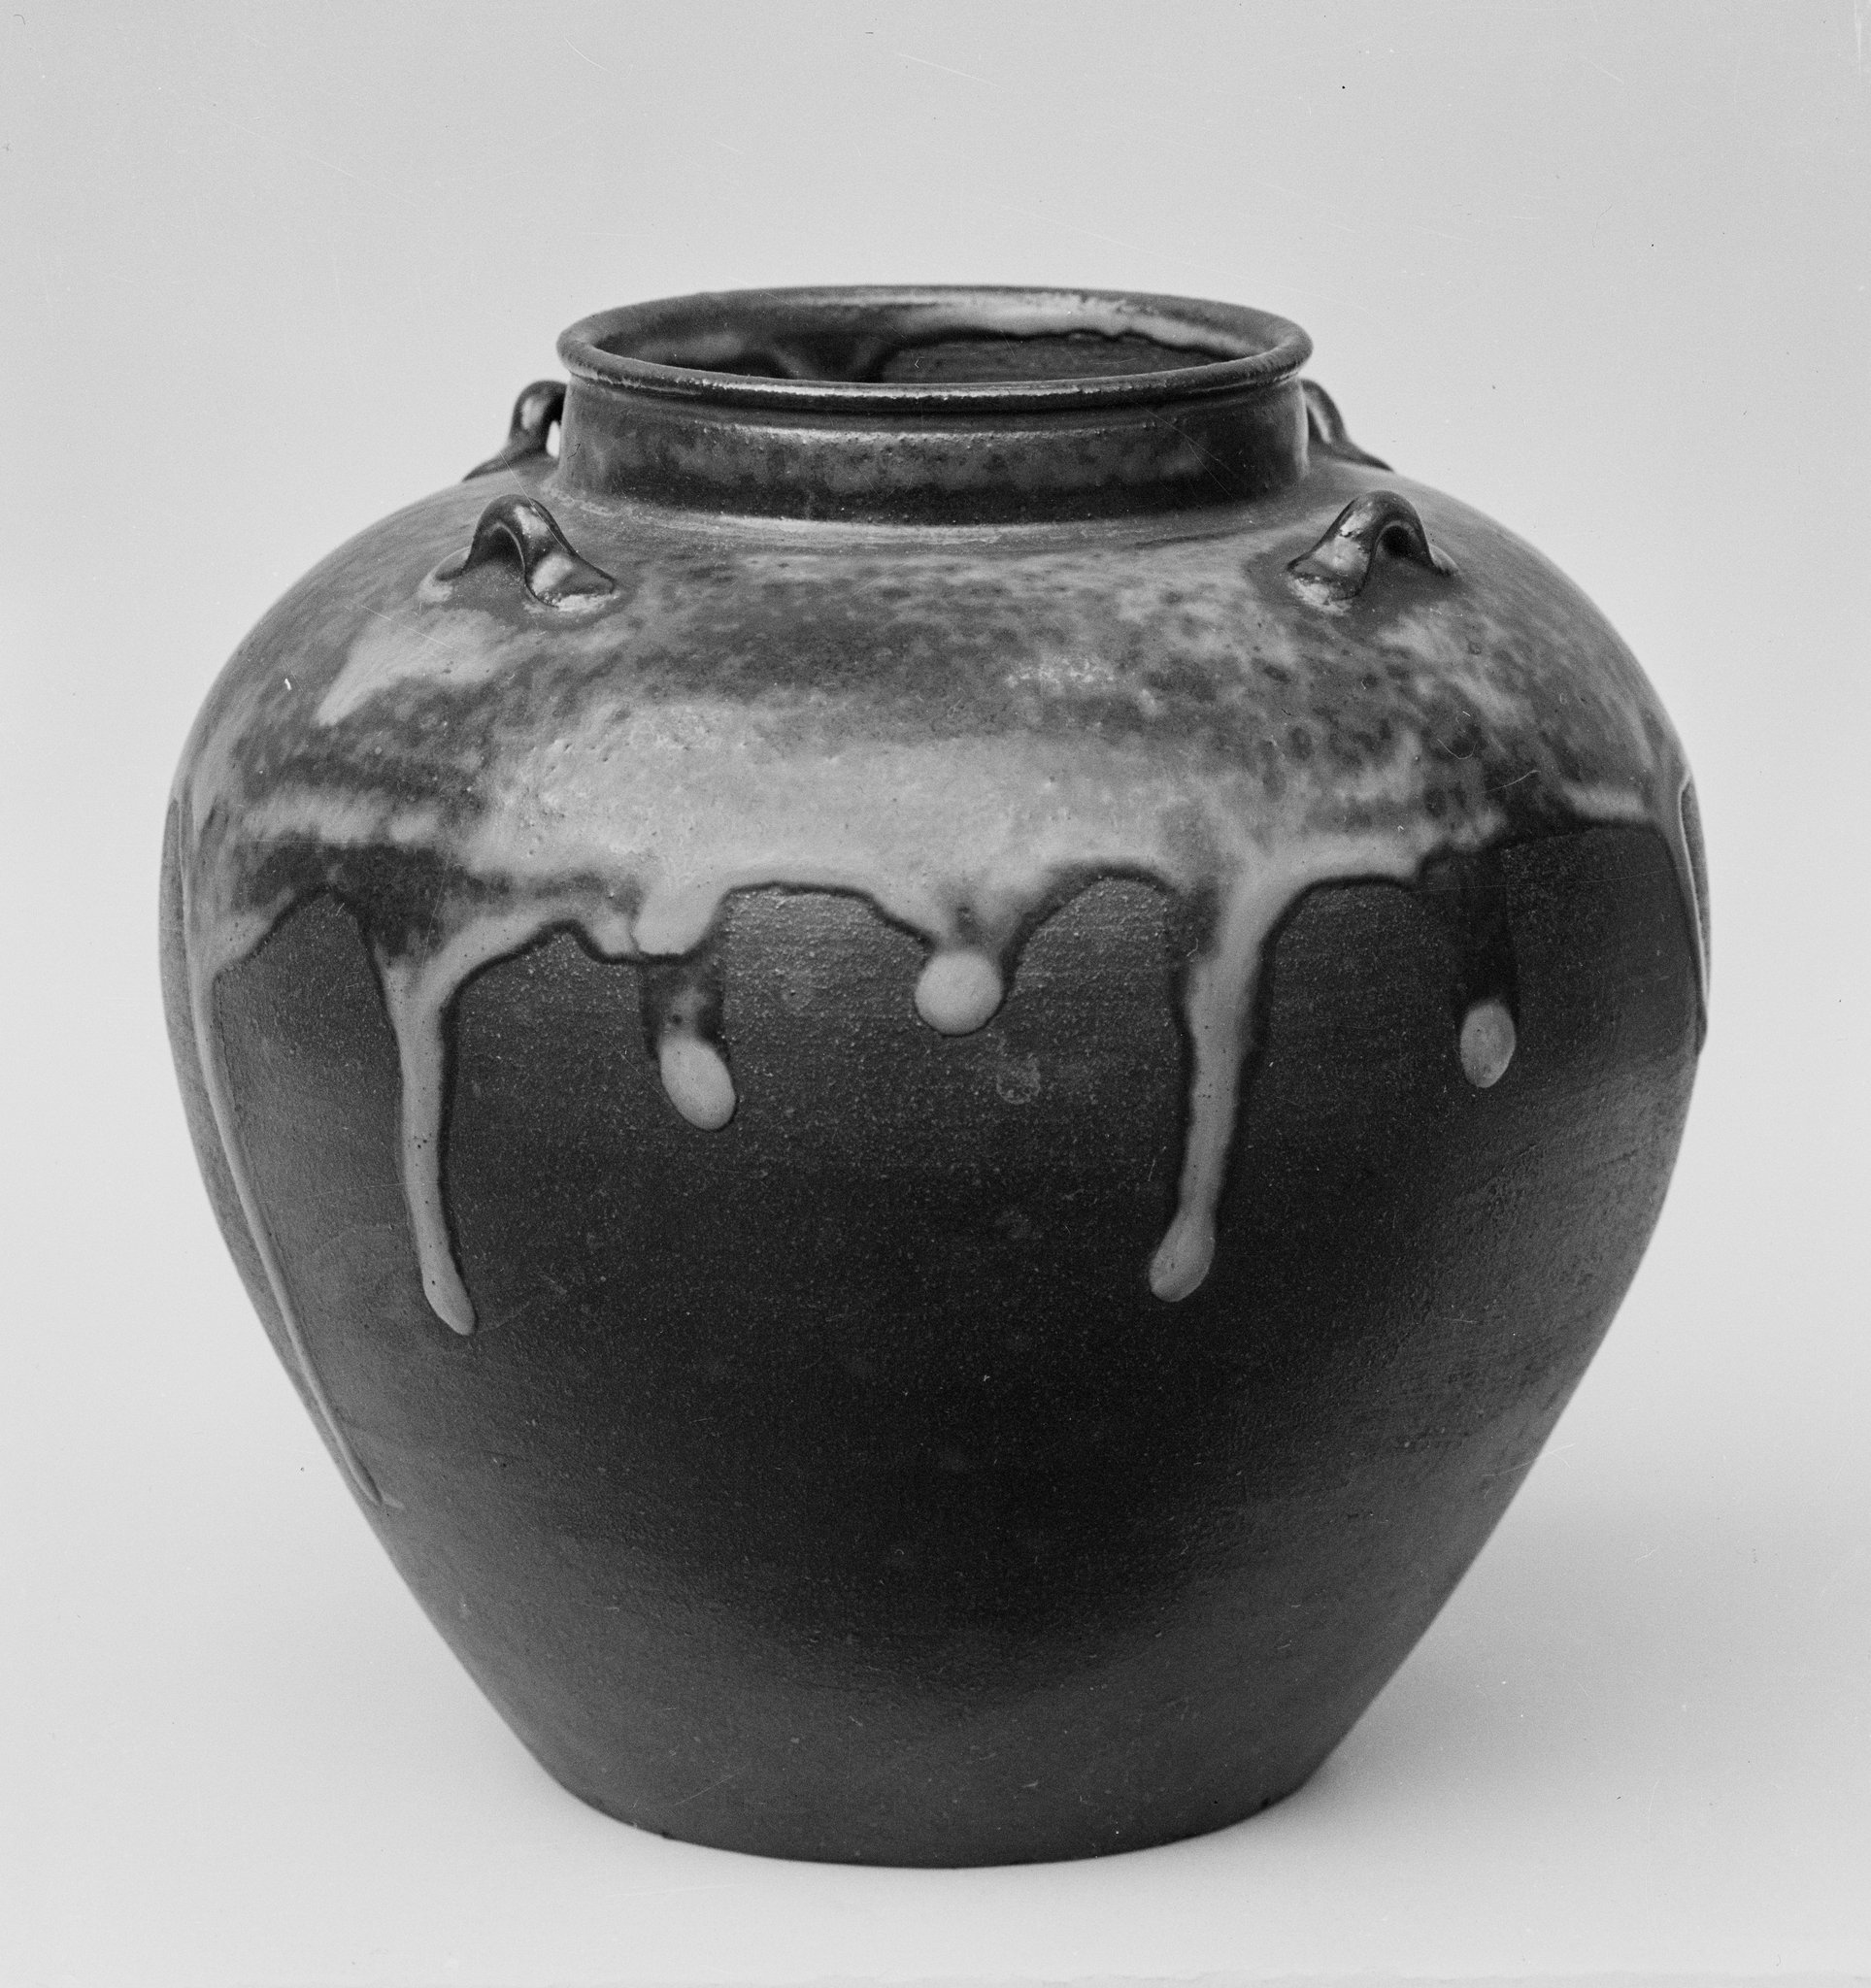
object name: jar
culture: japanese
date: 1601-1700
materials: clay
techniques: overglaze, underglaze